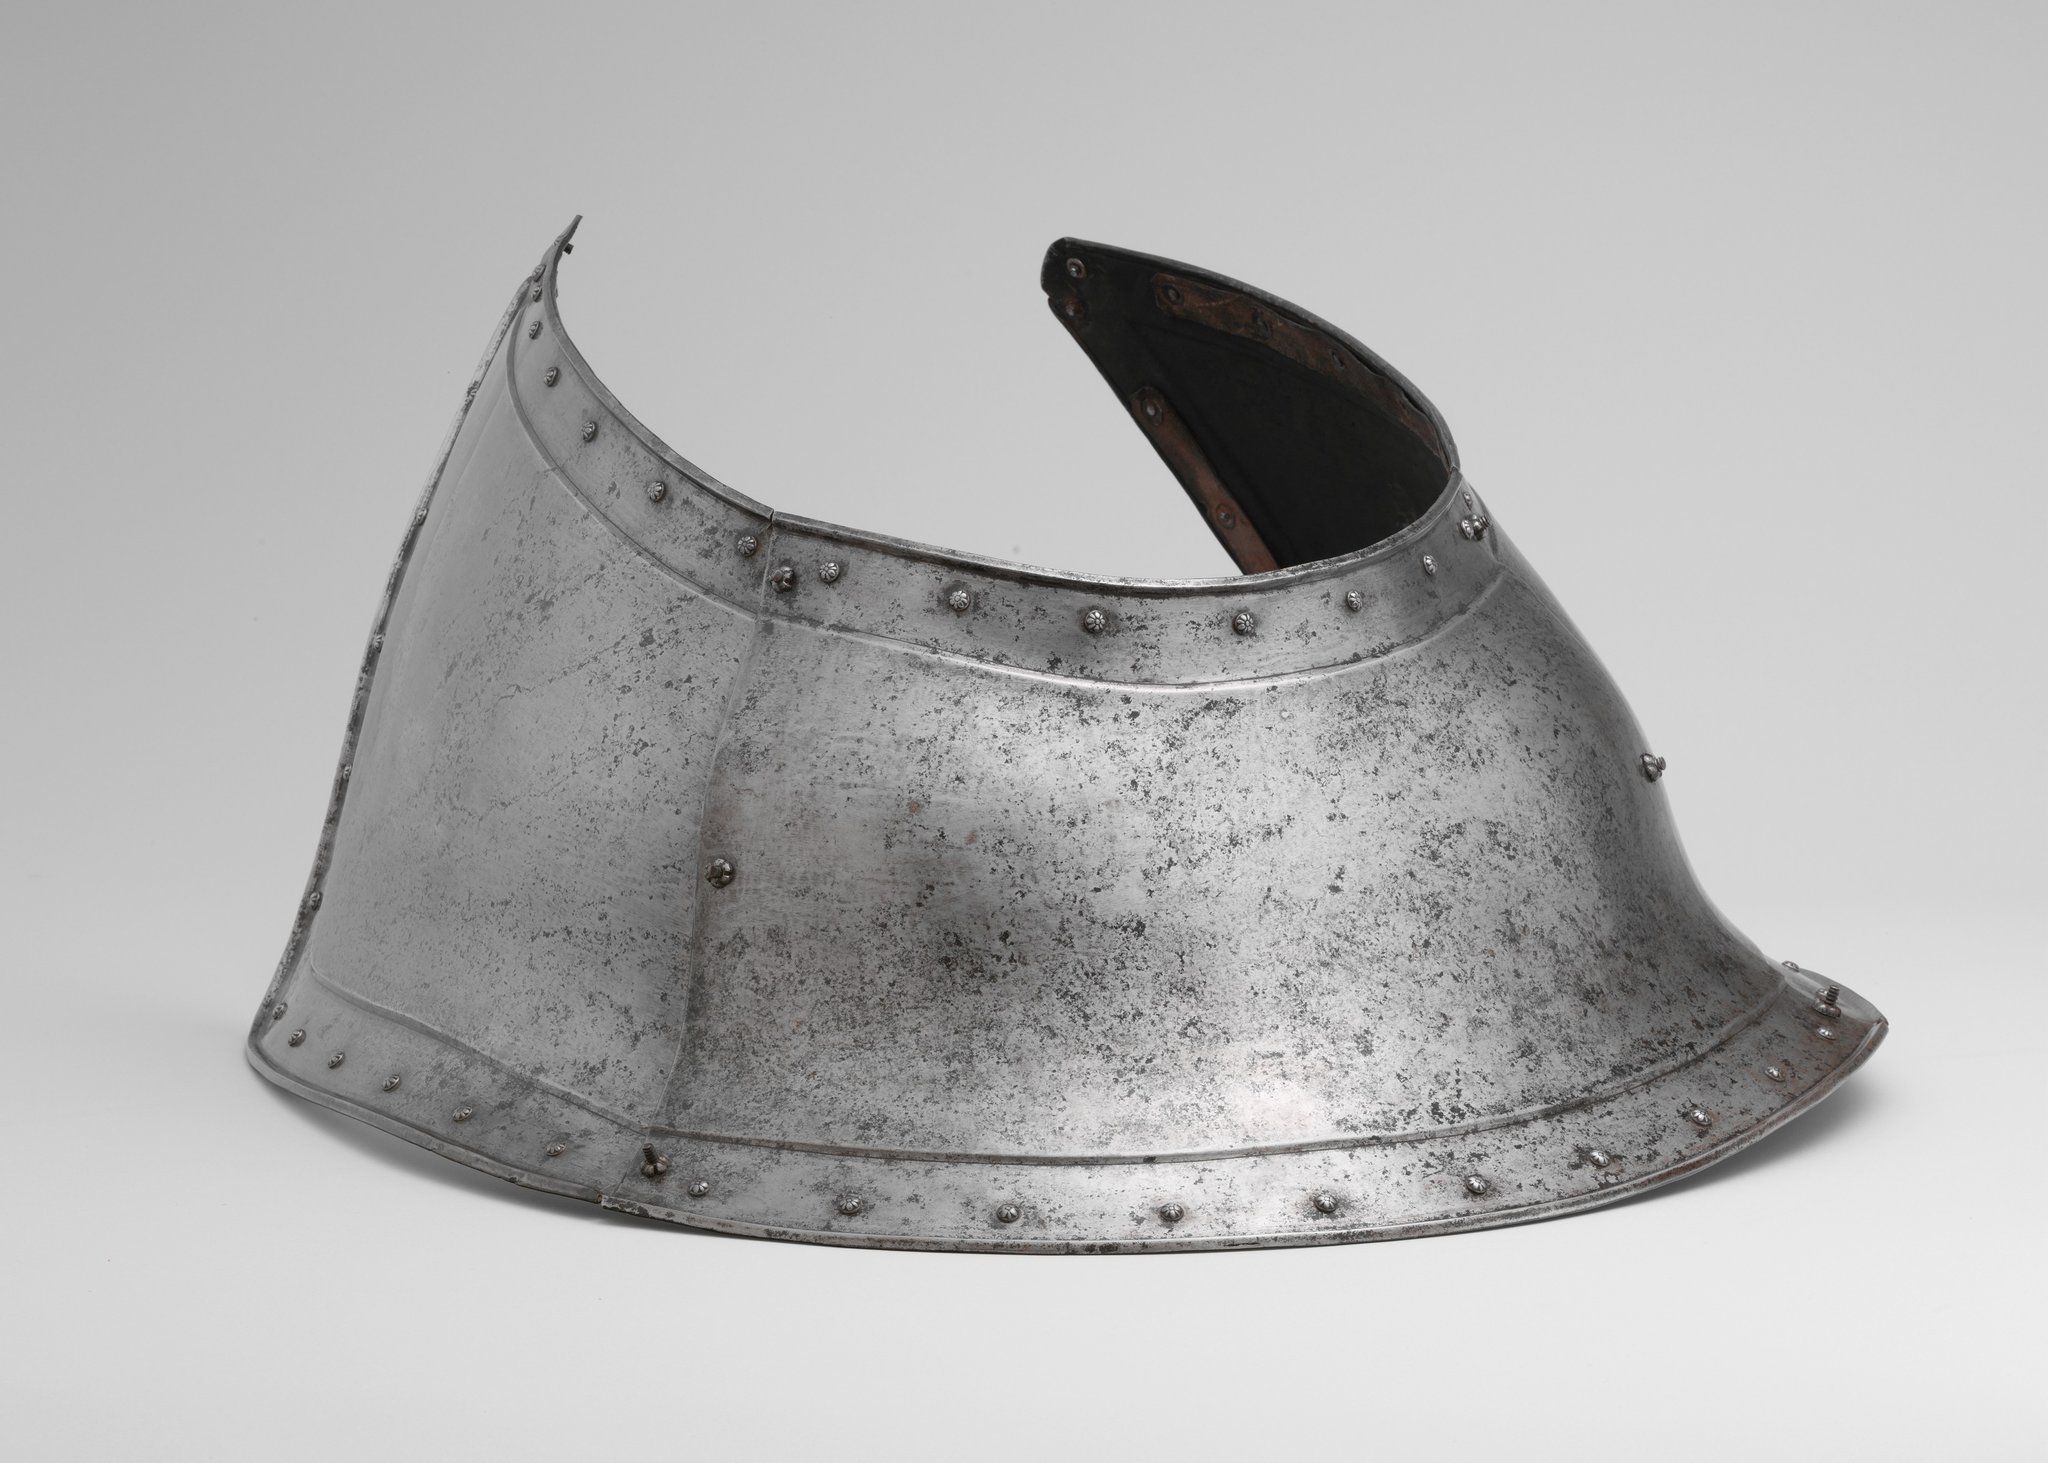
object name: peytral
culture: german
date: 1510-1520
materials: steel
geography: germany